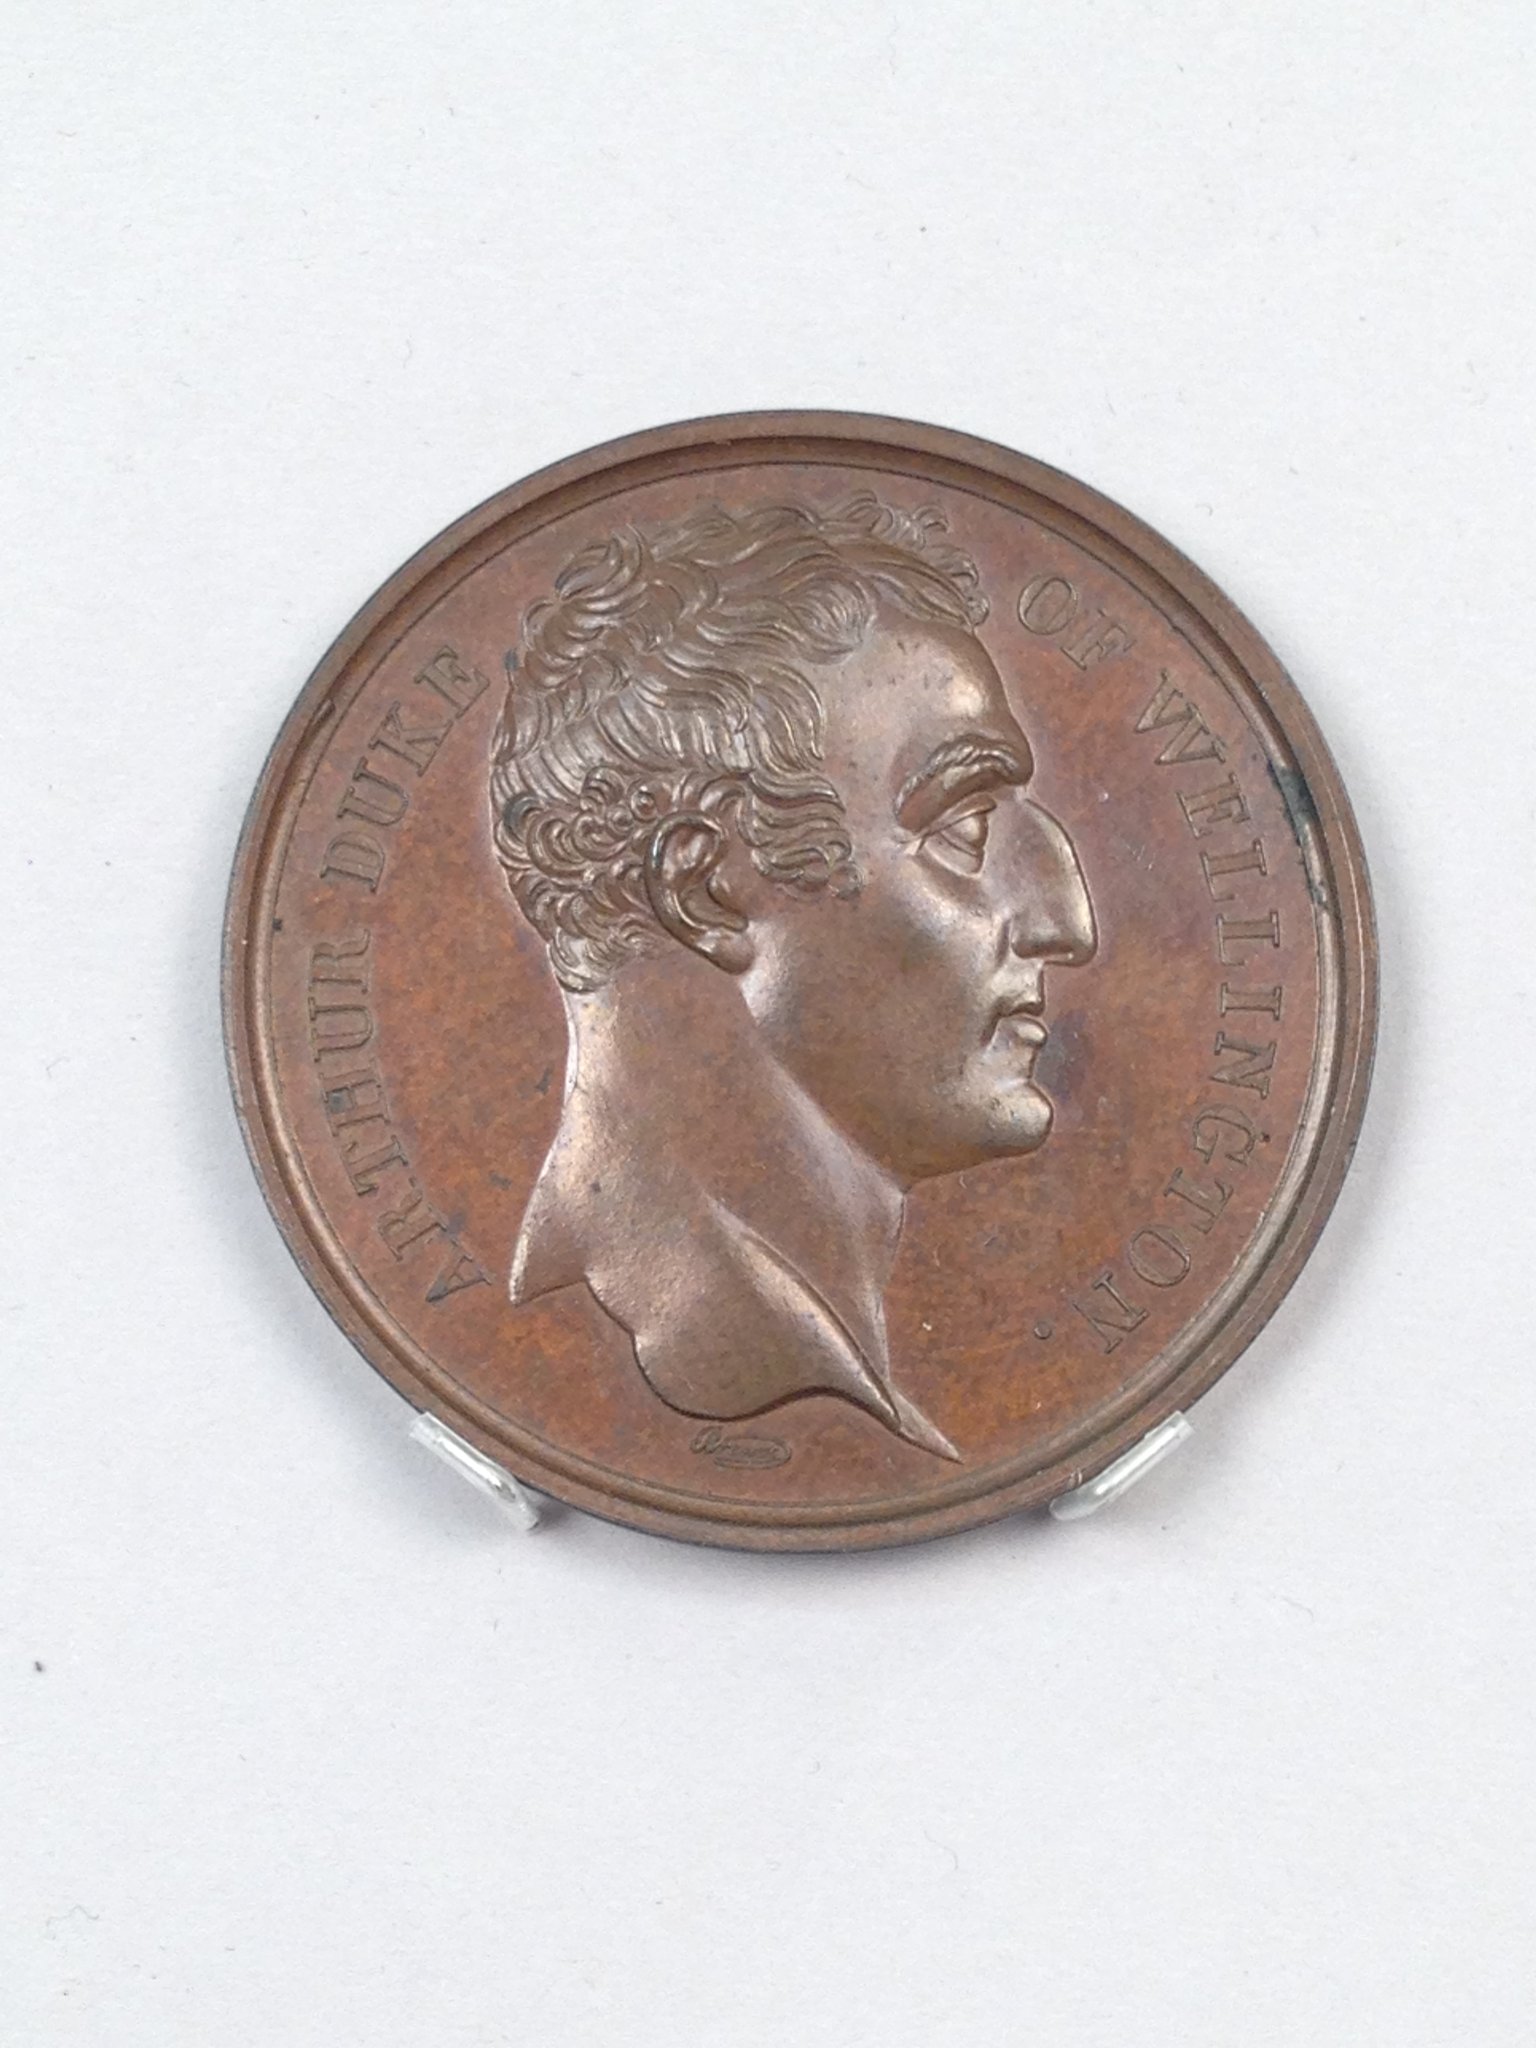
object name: medal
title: Duke of Wellington (one of Mudie's series of "National Medals")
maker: nicholas guy antoine brenet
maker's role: artist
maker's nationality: french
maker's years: 1773-1846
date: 1815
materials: bronze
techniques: struck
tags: men,profiles